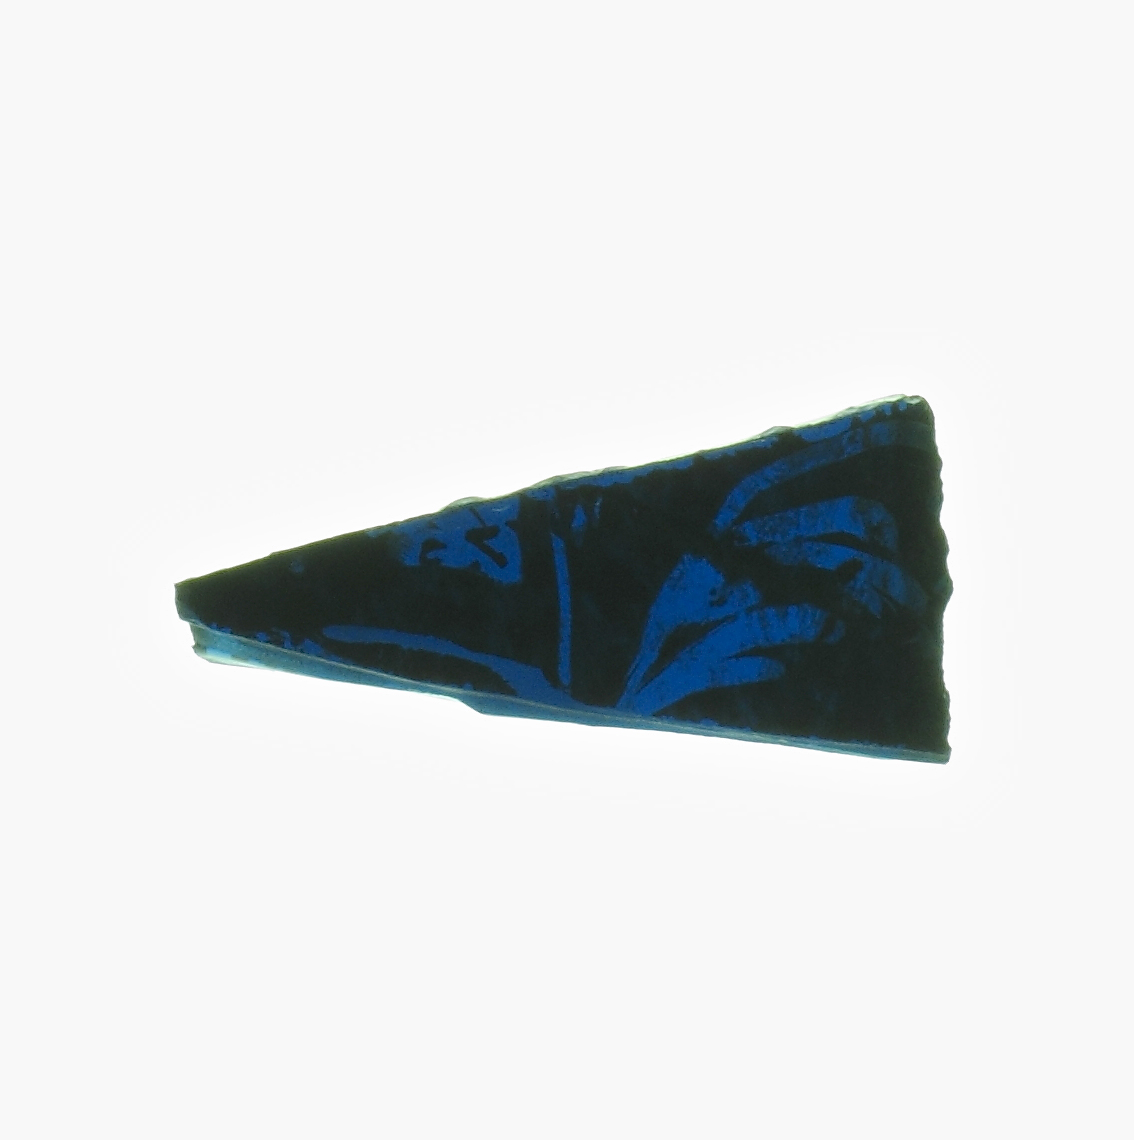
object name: fragment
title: Glass Fragment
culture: french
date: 1101-1400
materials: glass, metal, paint